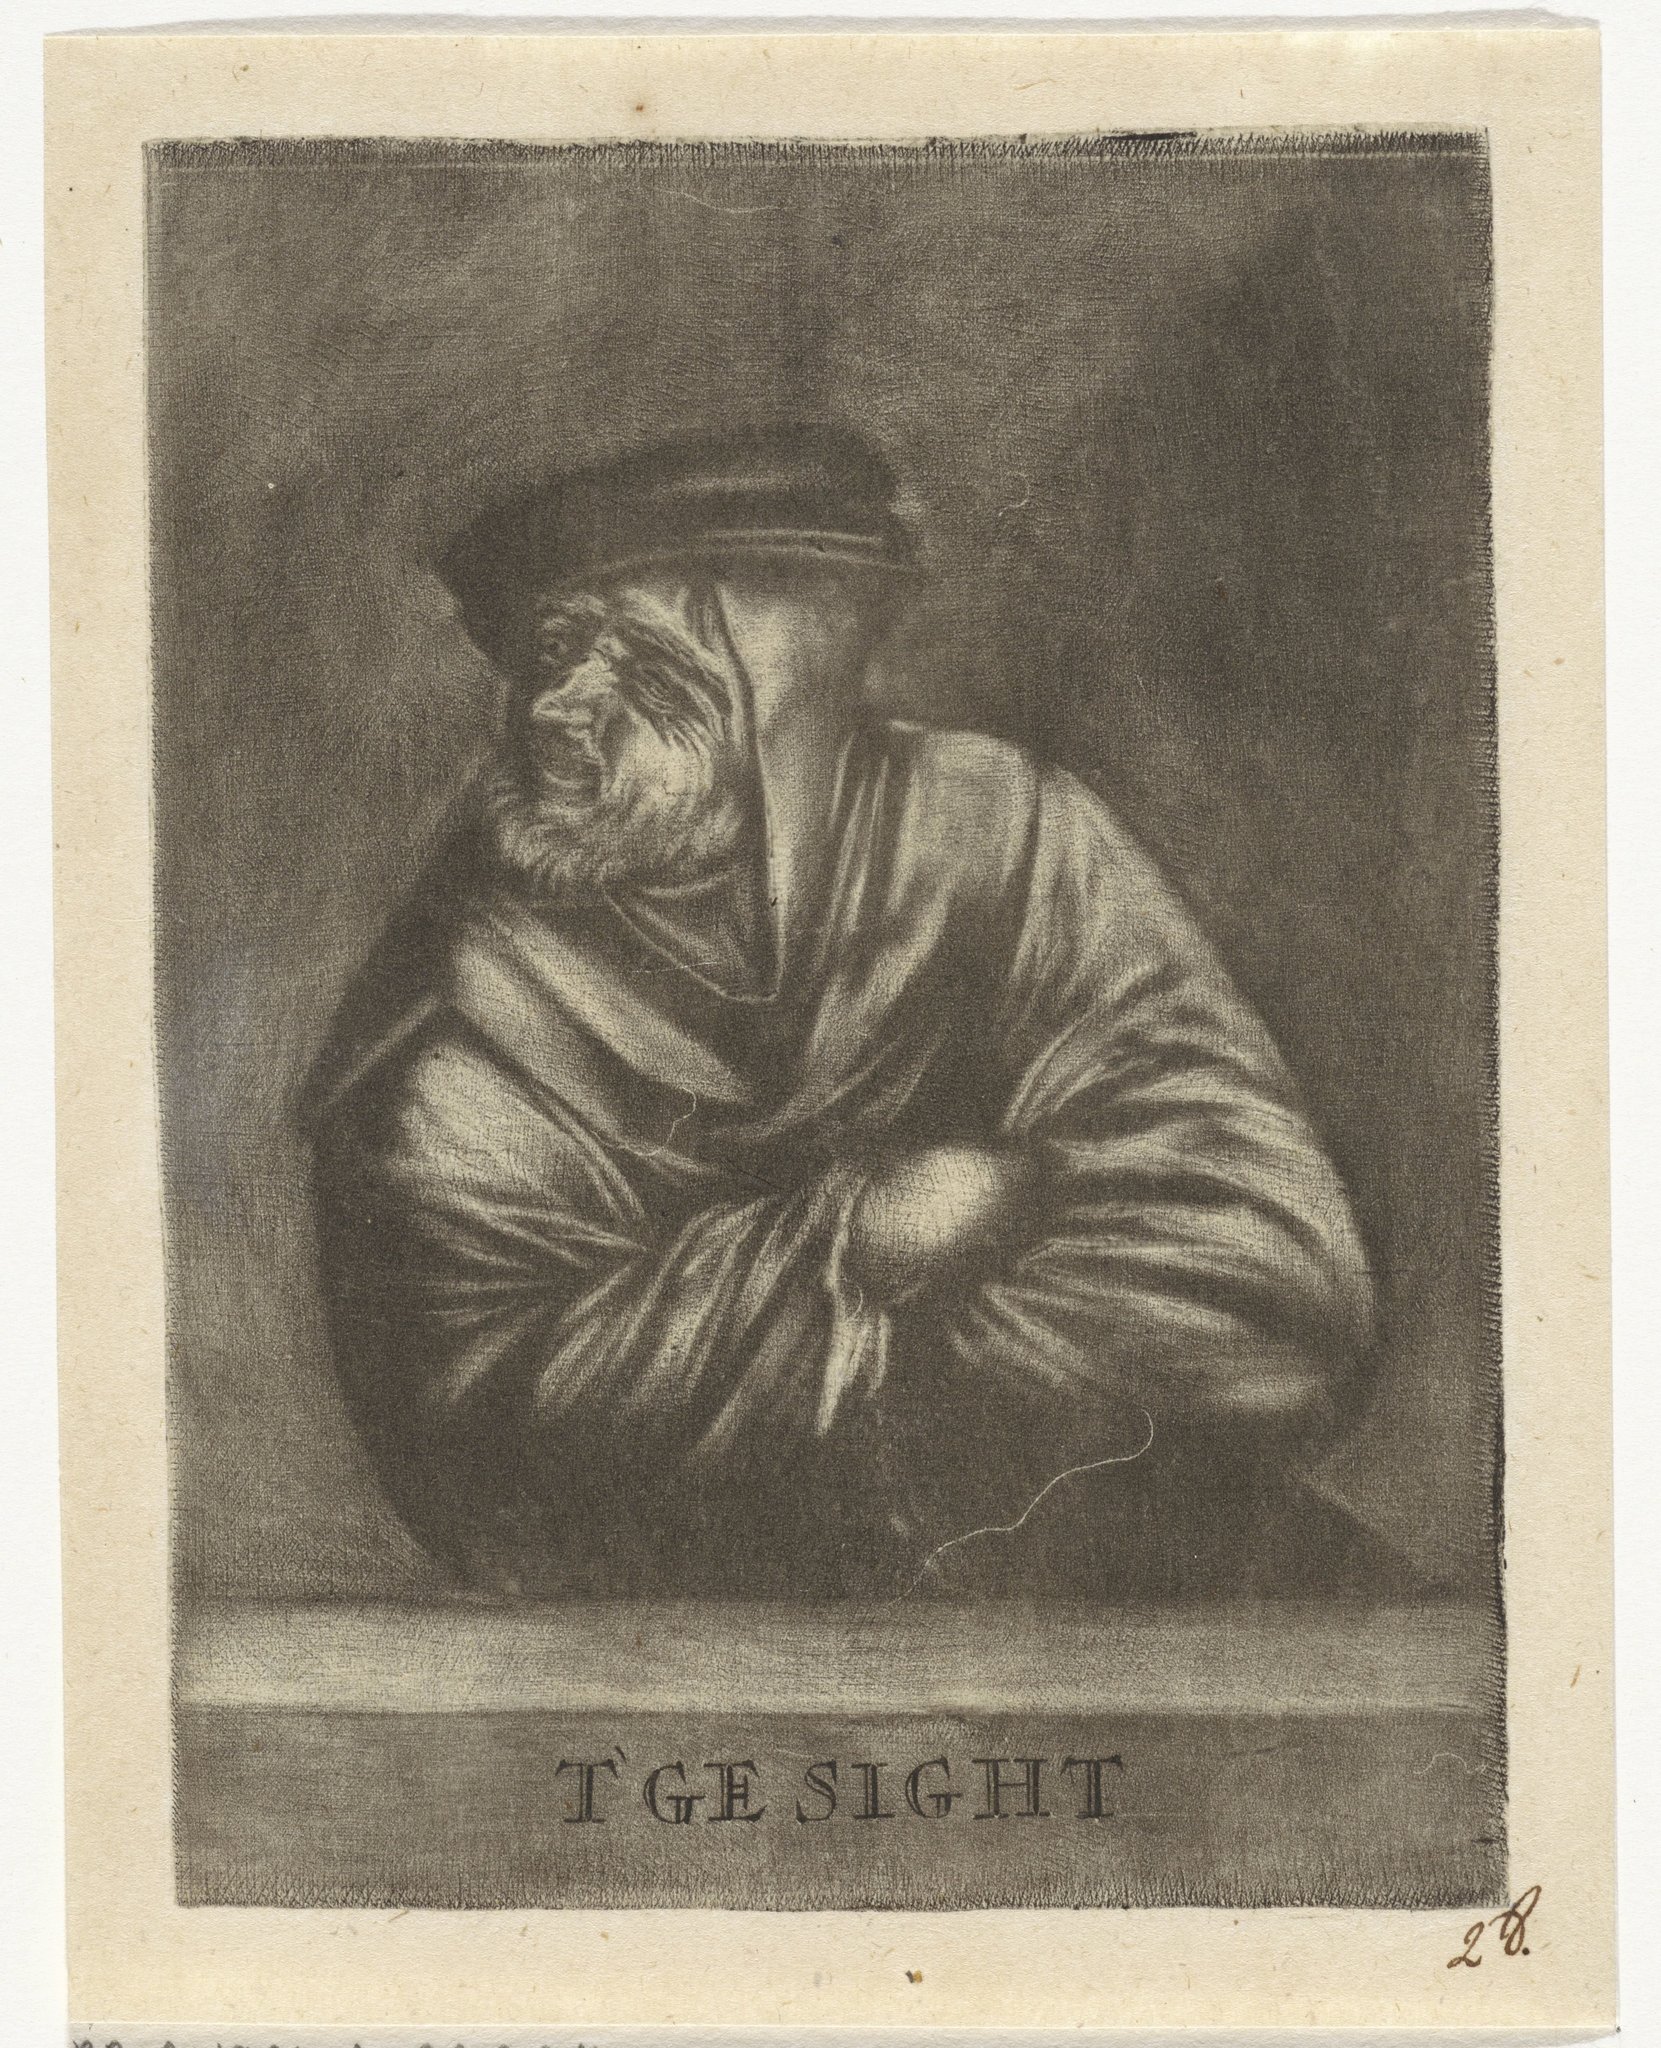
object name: print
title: T' Gesight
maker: pieter pickaert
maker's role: print maker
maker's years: 1668-1737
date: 1680-1715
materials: paper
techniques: mezzotint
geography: amsterdam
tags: sight, looking (one of the five senses), head-gear: cap (+ men's clothes)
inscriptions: collector's mark: Lugt 2228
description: Het zintuig Gezicht. Een man kijkt met toegeknepen ogen en met de armen over elkaar naar rechts. Hij draagt een hoed.